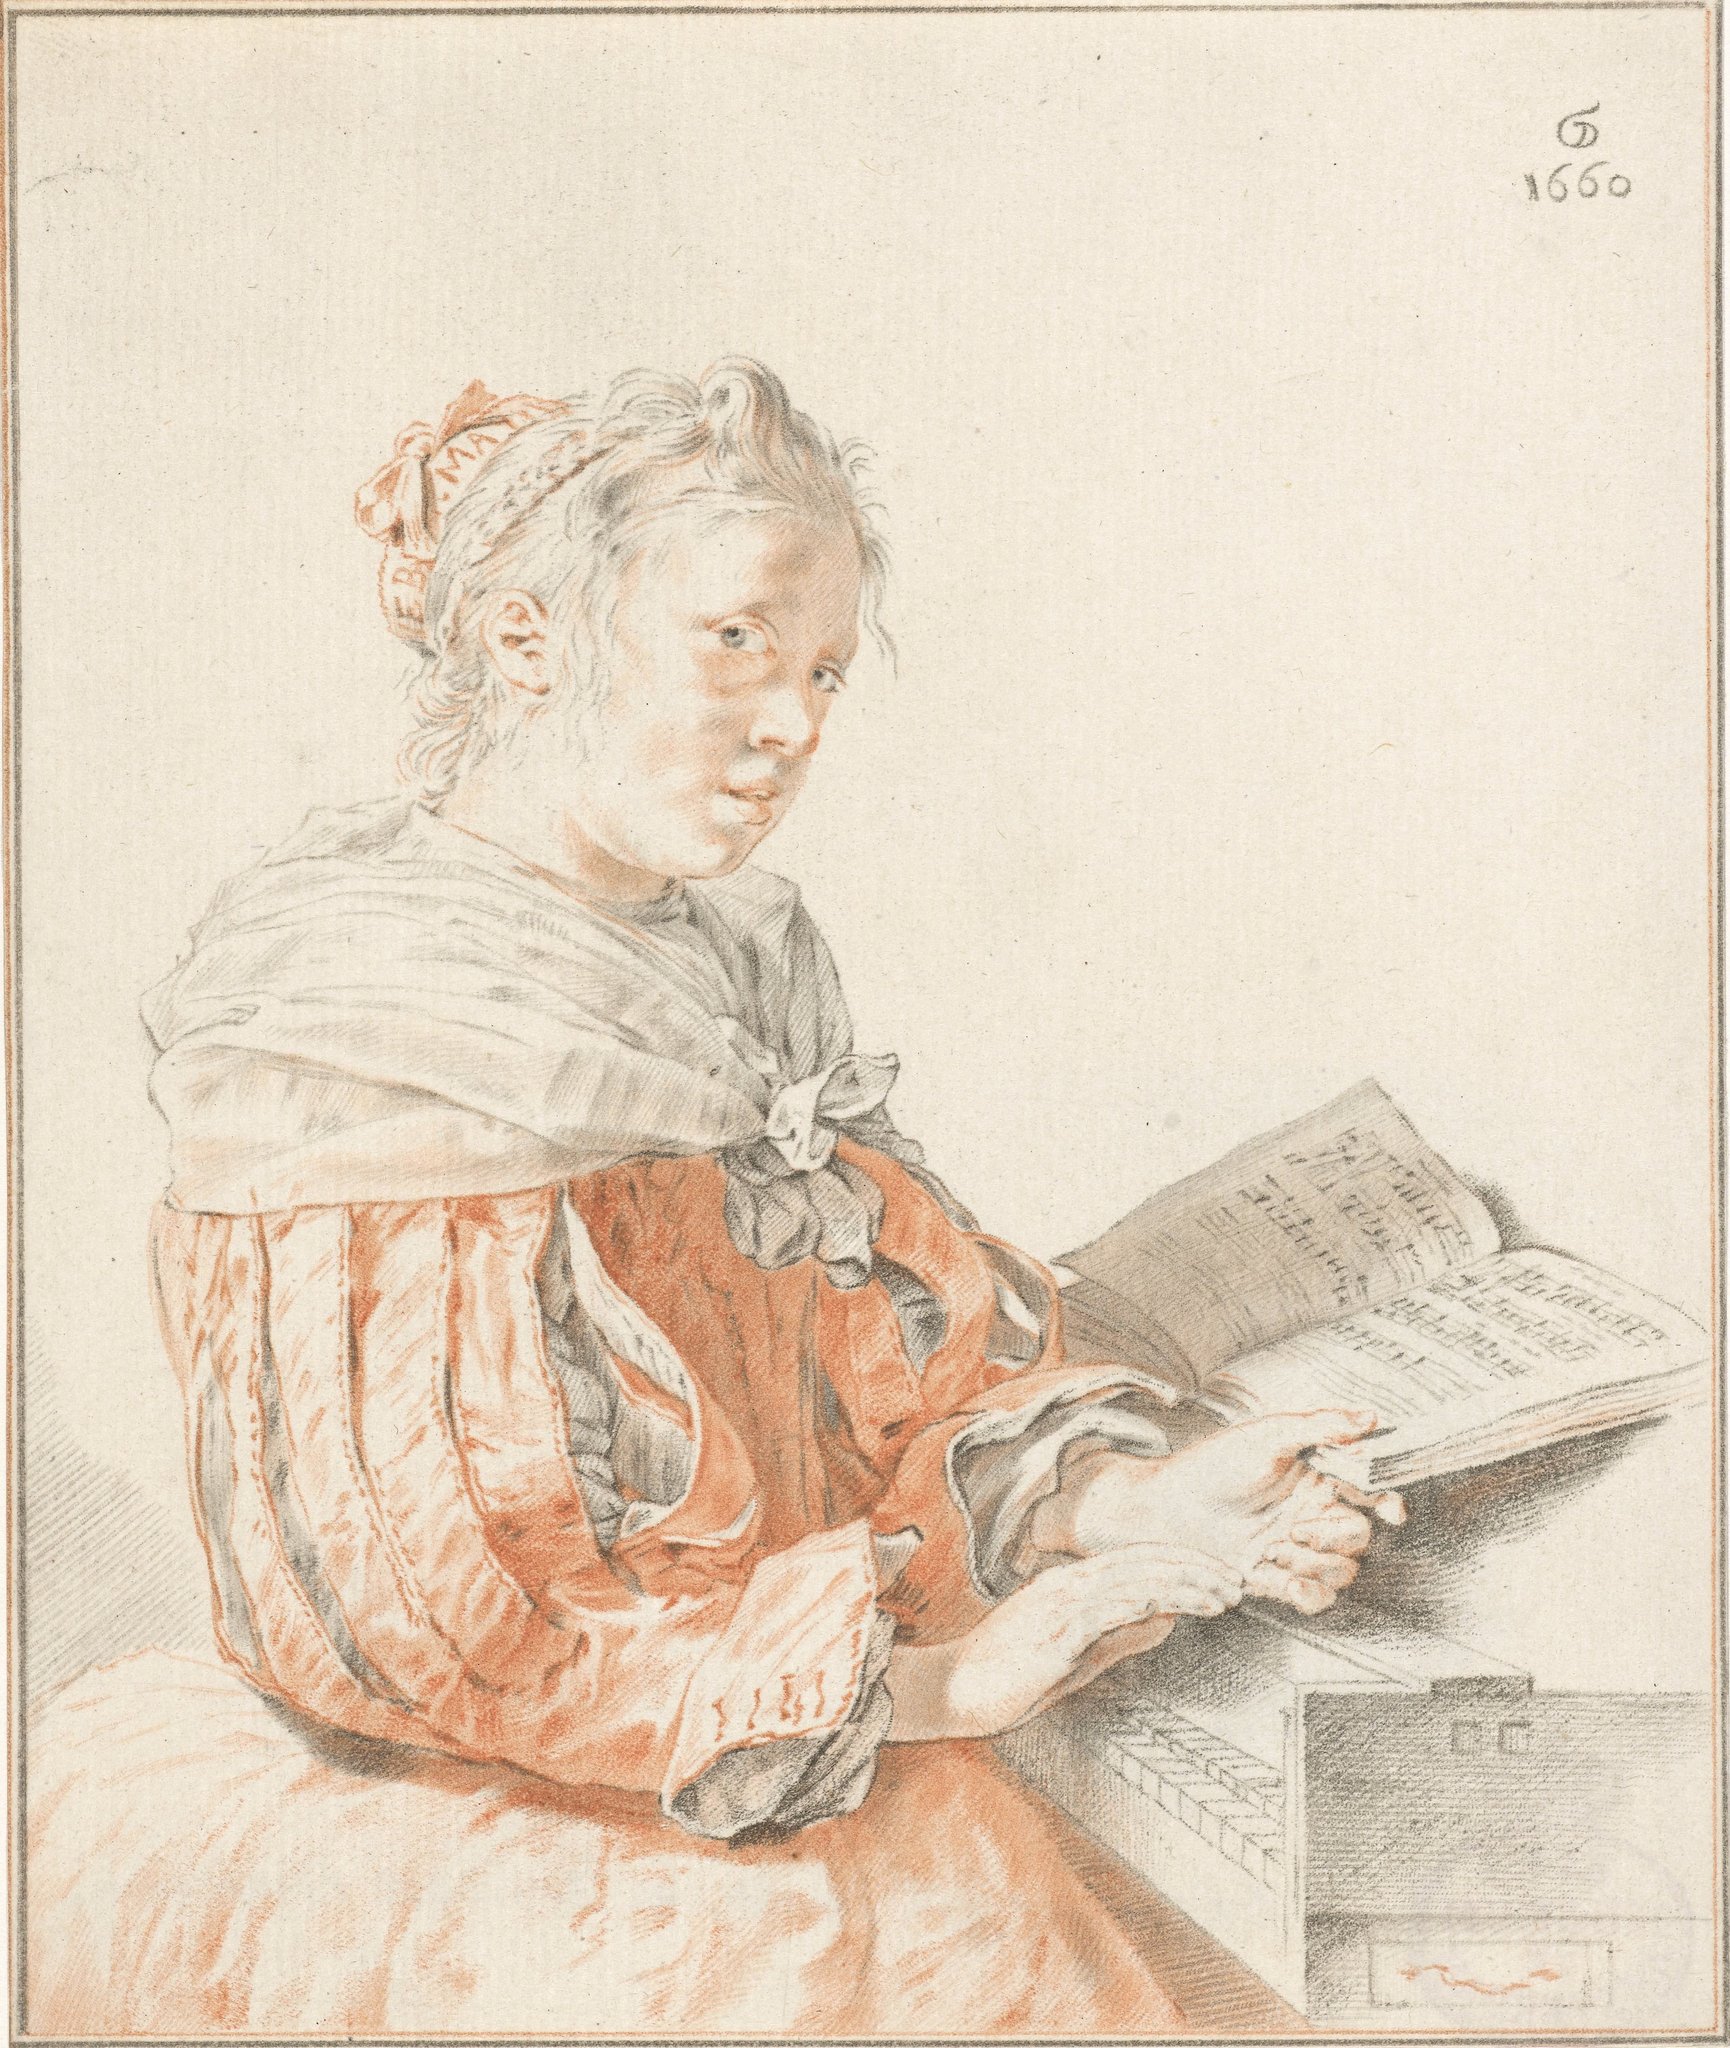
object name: print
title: Klavierspeelster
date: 1767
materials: paper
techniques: printing, printmaking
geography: amsterdam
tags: adult woman, keyboard instruments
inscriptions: collector's mark: Lugt 12, collector's mark: Lugt 2725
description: Een vrouw, gekleed in een japon met mouwen met splitten, aan het klavier.